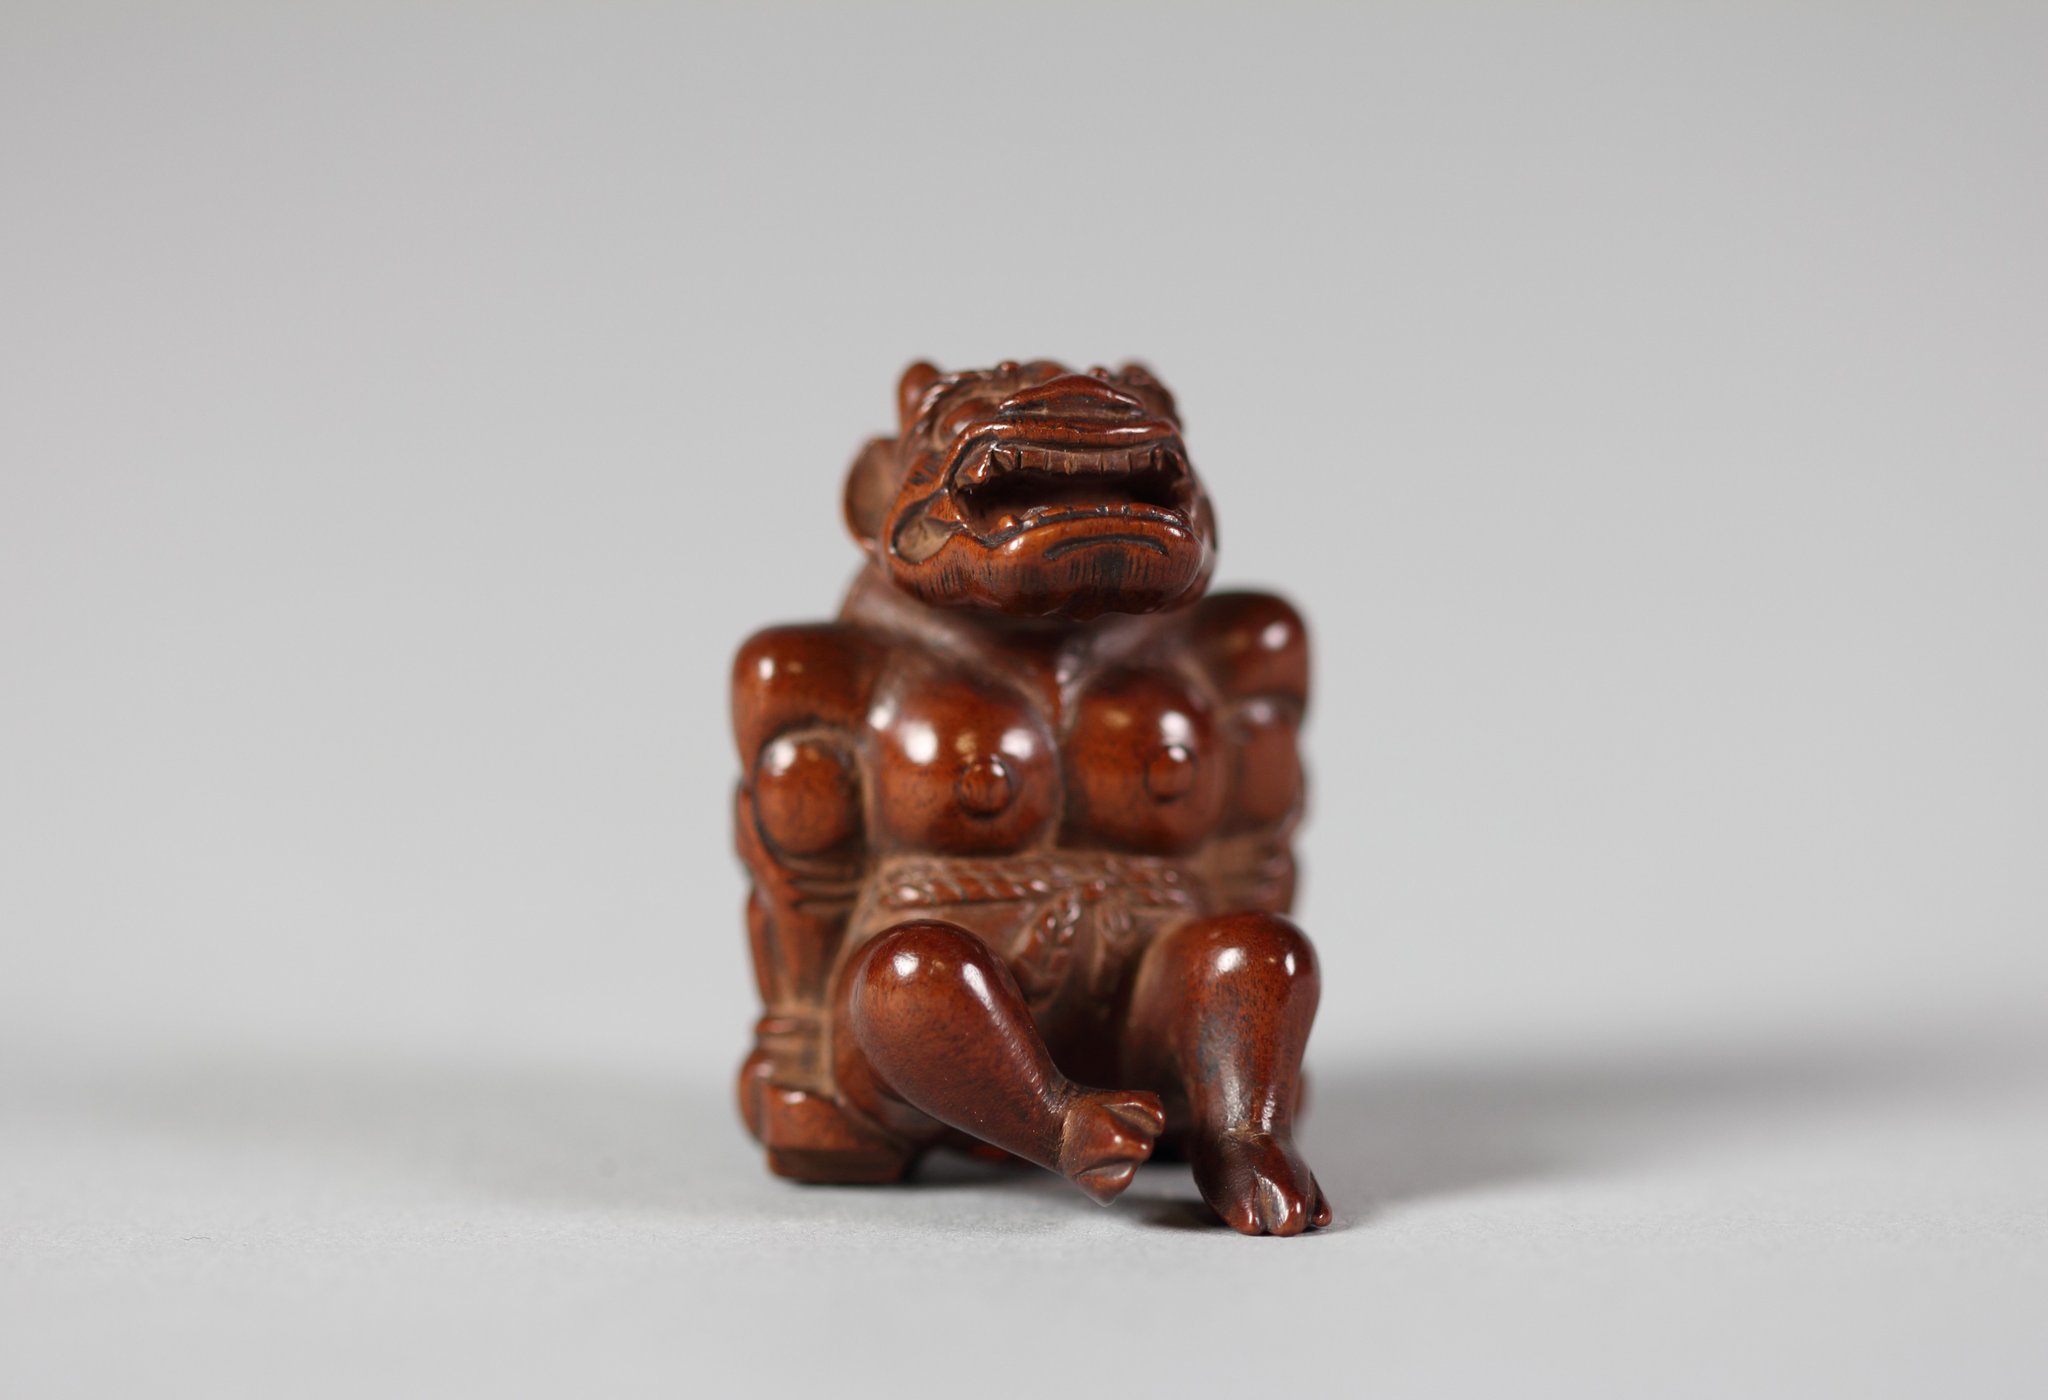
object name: netsuke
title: Netsuke of Demon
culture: japanese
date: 1801-1900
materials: wood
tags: demons